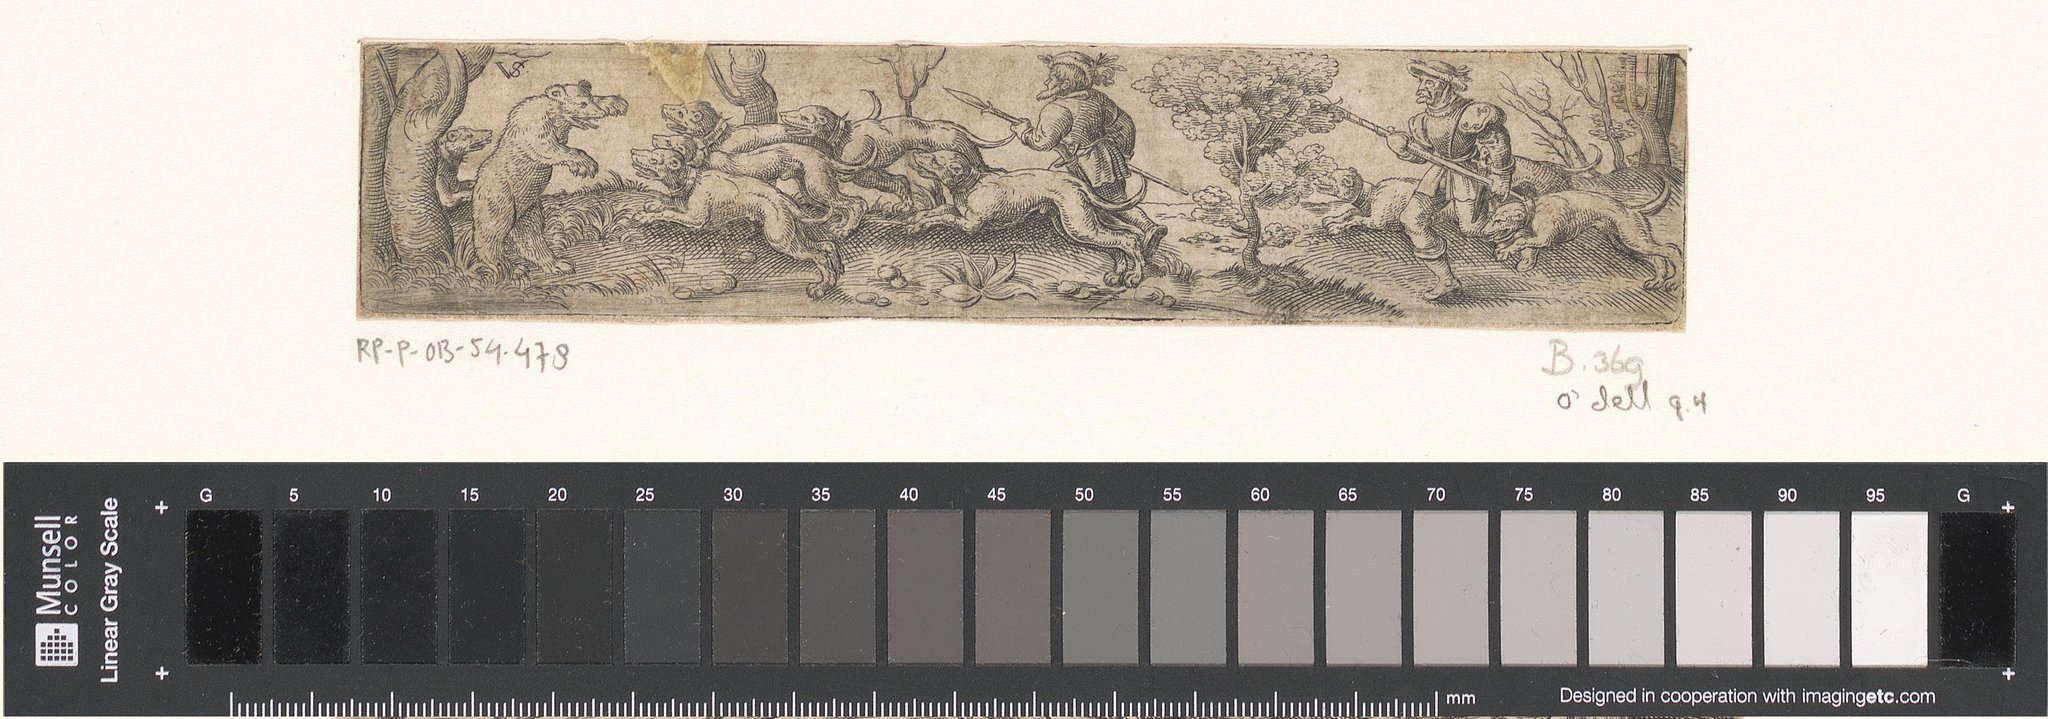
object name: print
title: Berenjacht met links een staande beer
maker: virgilius solis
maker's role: draughtsman, print maker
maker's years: 1514-1562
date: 1524-1562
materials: paper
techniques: engraving, etching, intaglio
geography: nuremberg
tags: hunting dogs, beasts of prey, predatory animals: bear, hunt ~ mammals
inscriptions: collector's mark: Lugt 2228, number: ‘34’